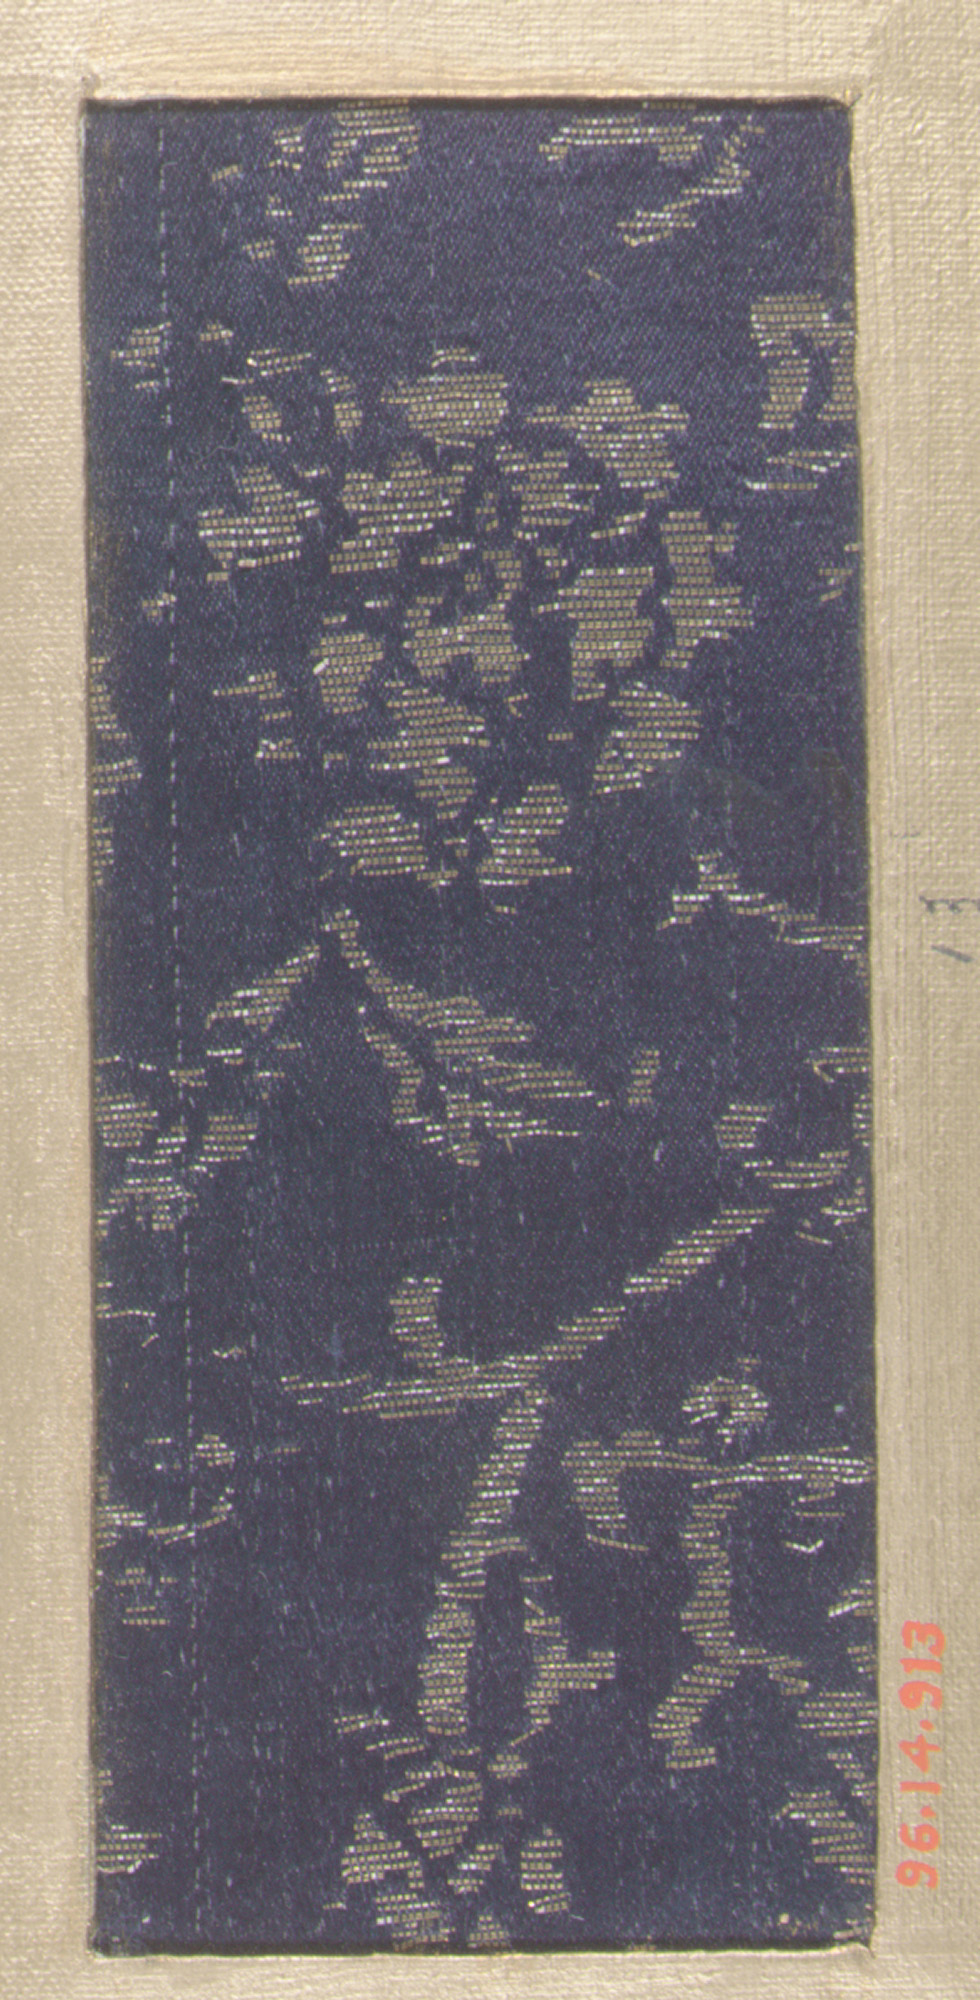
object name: piece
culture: japanese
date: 1701-1900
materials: silk